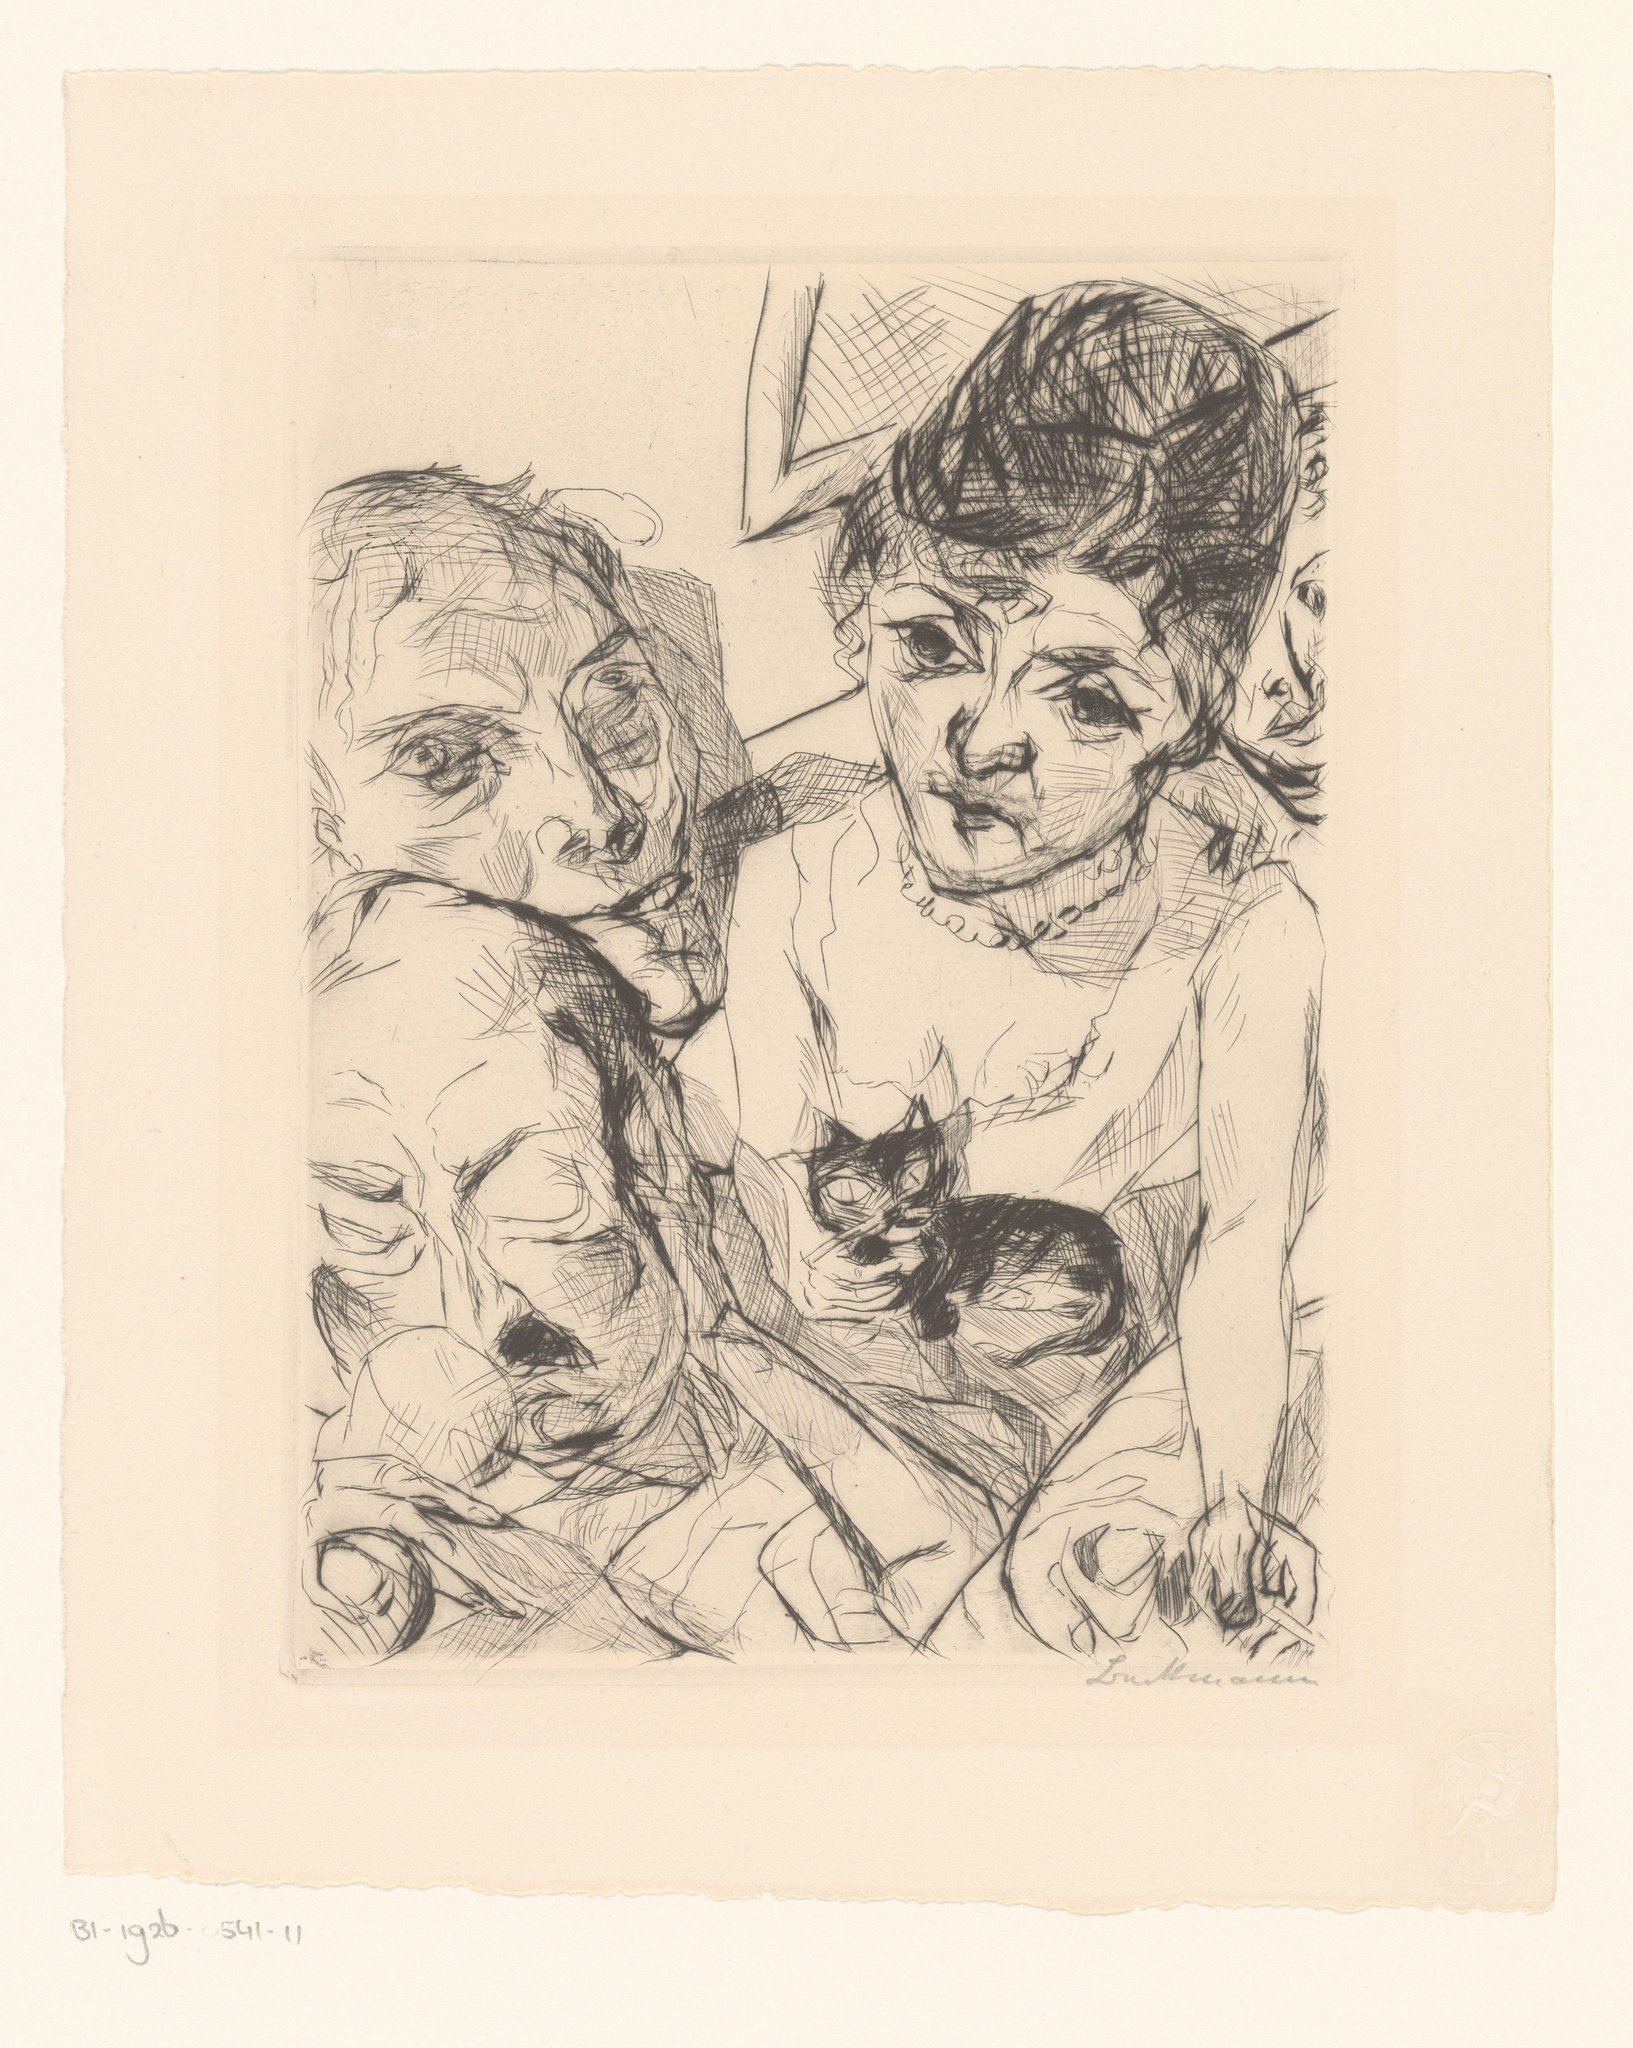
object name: print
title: Avond (zelfportret met de Battenbergs)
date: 1916-1919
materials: paper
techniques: drypoint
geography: munich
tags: new york (city), max beckmann, family life at home, friendship between man and animal; caressing, petting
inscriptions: collector's mark: Lugt 5629, collector's mark: Lugt 2166